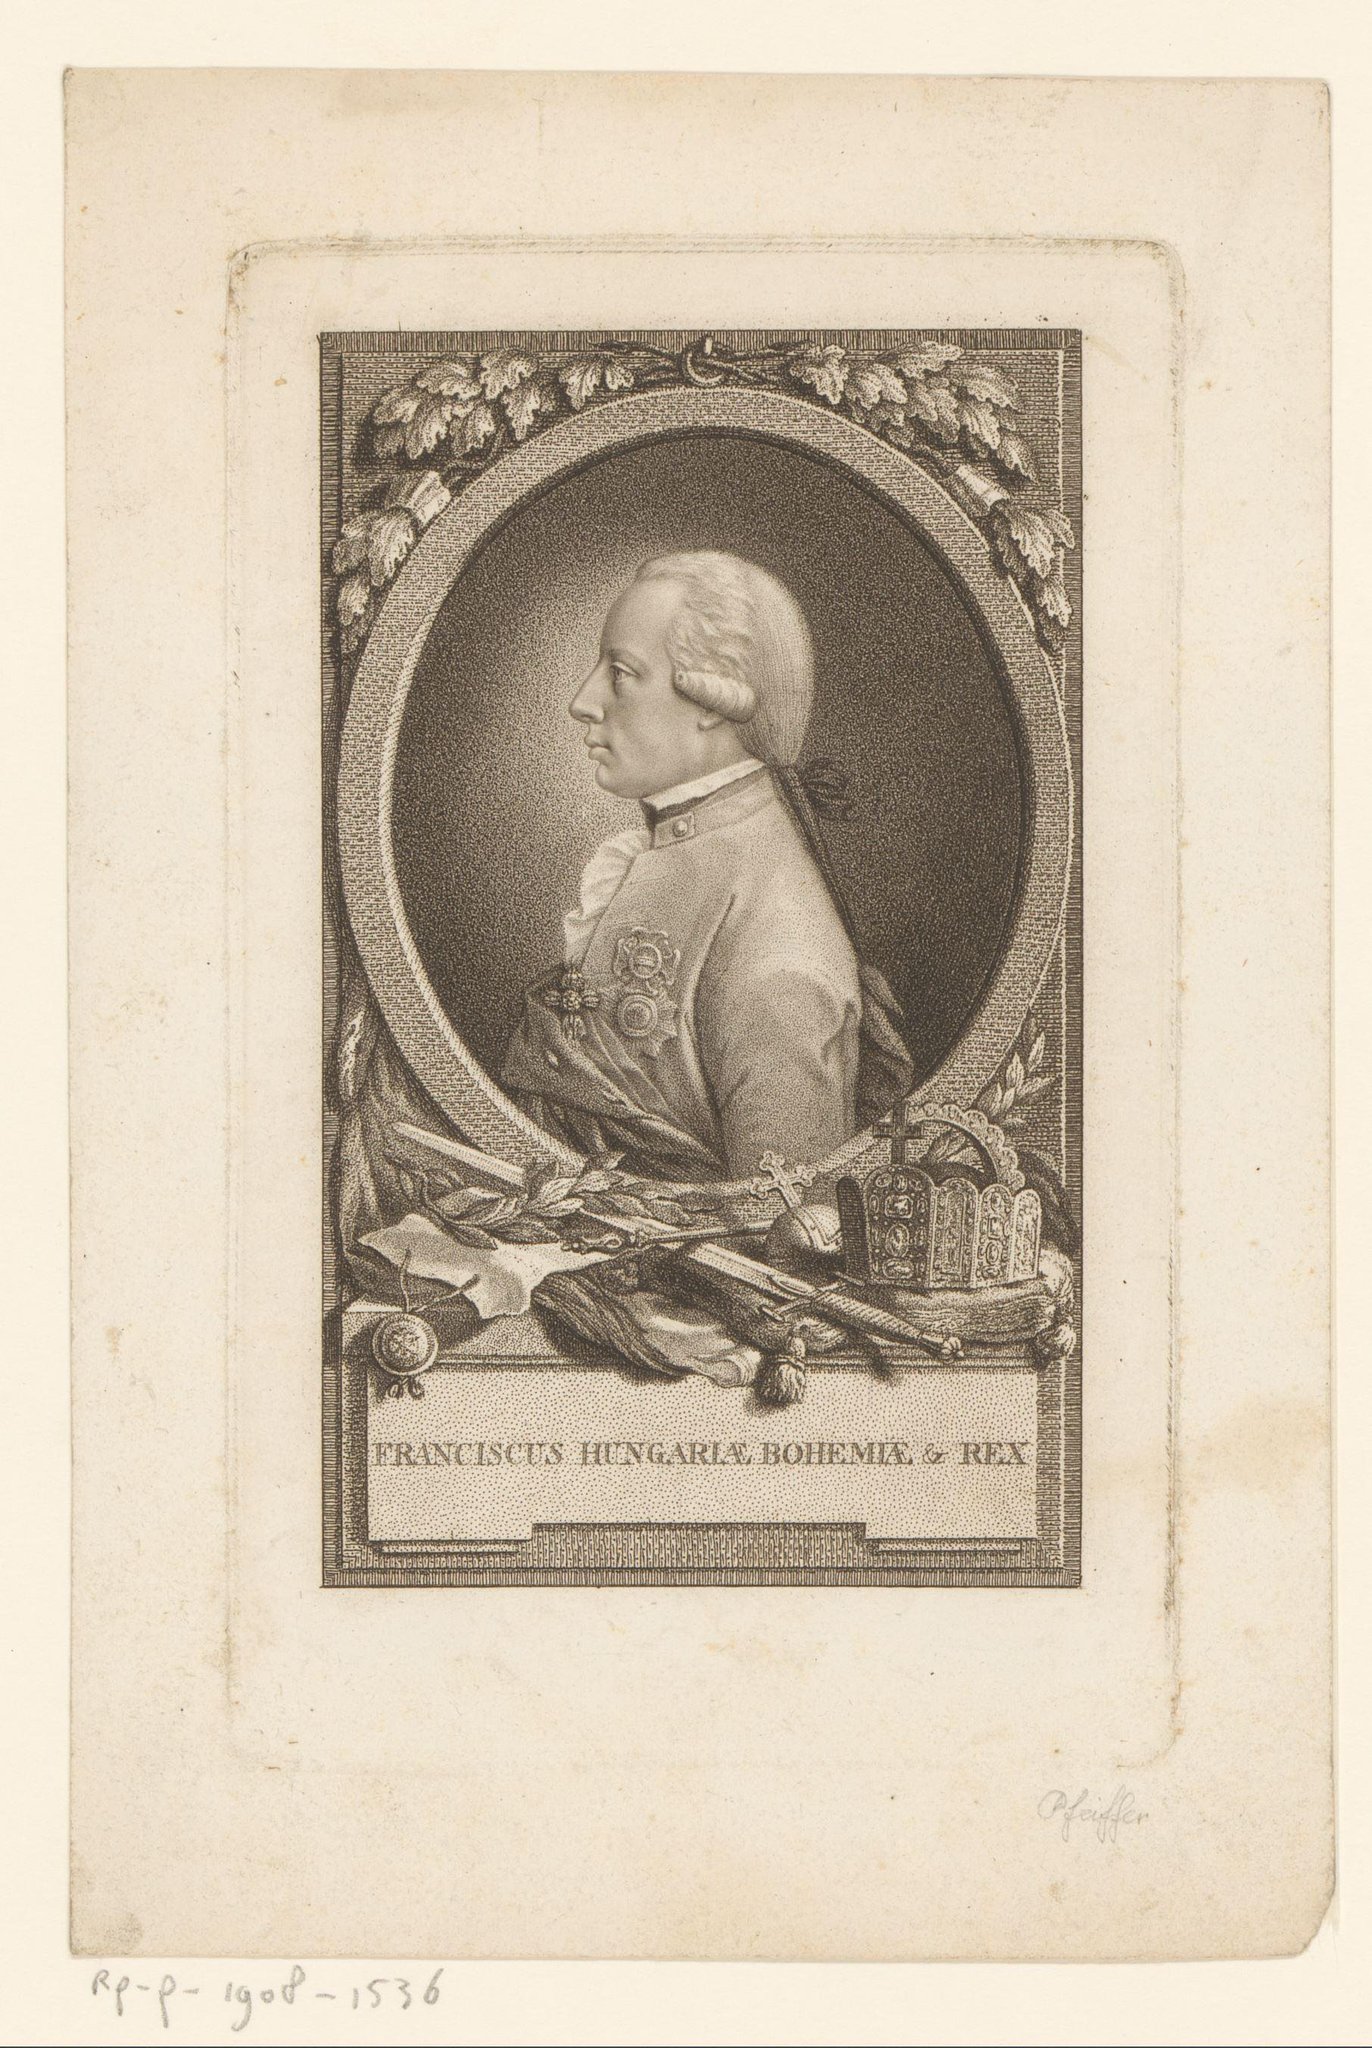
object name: print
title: Portret van Jozef II, Duits keizer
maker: carl hermann pfeiffer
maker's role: print maker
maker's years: 1769-1829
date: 1779-1829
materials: paper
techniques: engraving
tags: vienna, jozef ii (duits keizer), historical persons, insignia and symbols of sovereignty (crown, diadem, sceptre, orb, seal, standard, cloak, pectoral)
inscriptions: collector's mark: Lugt 2228